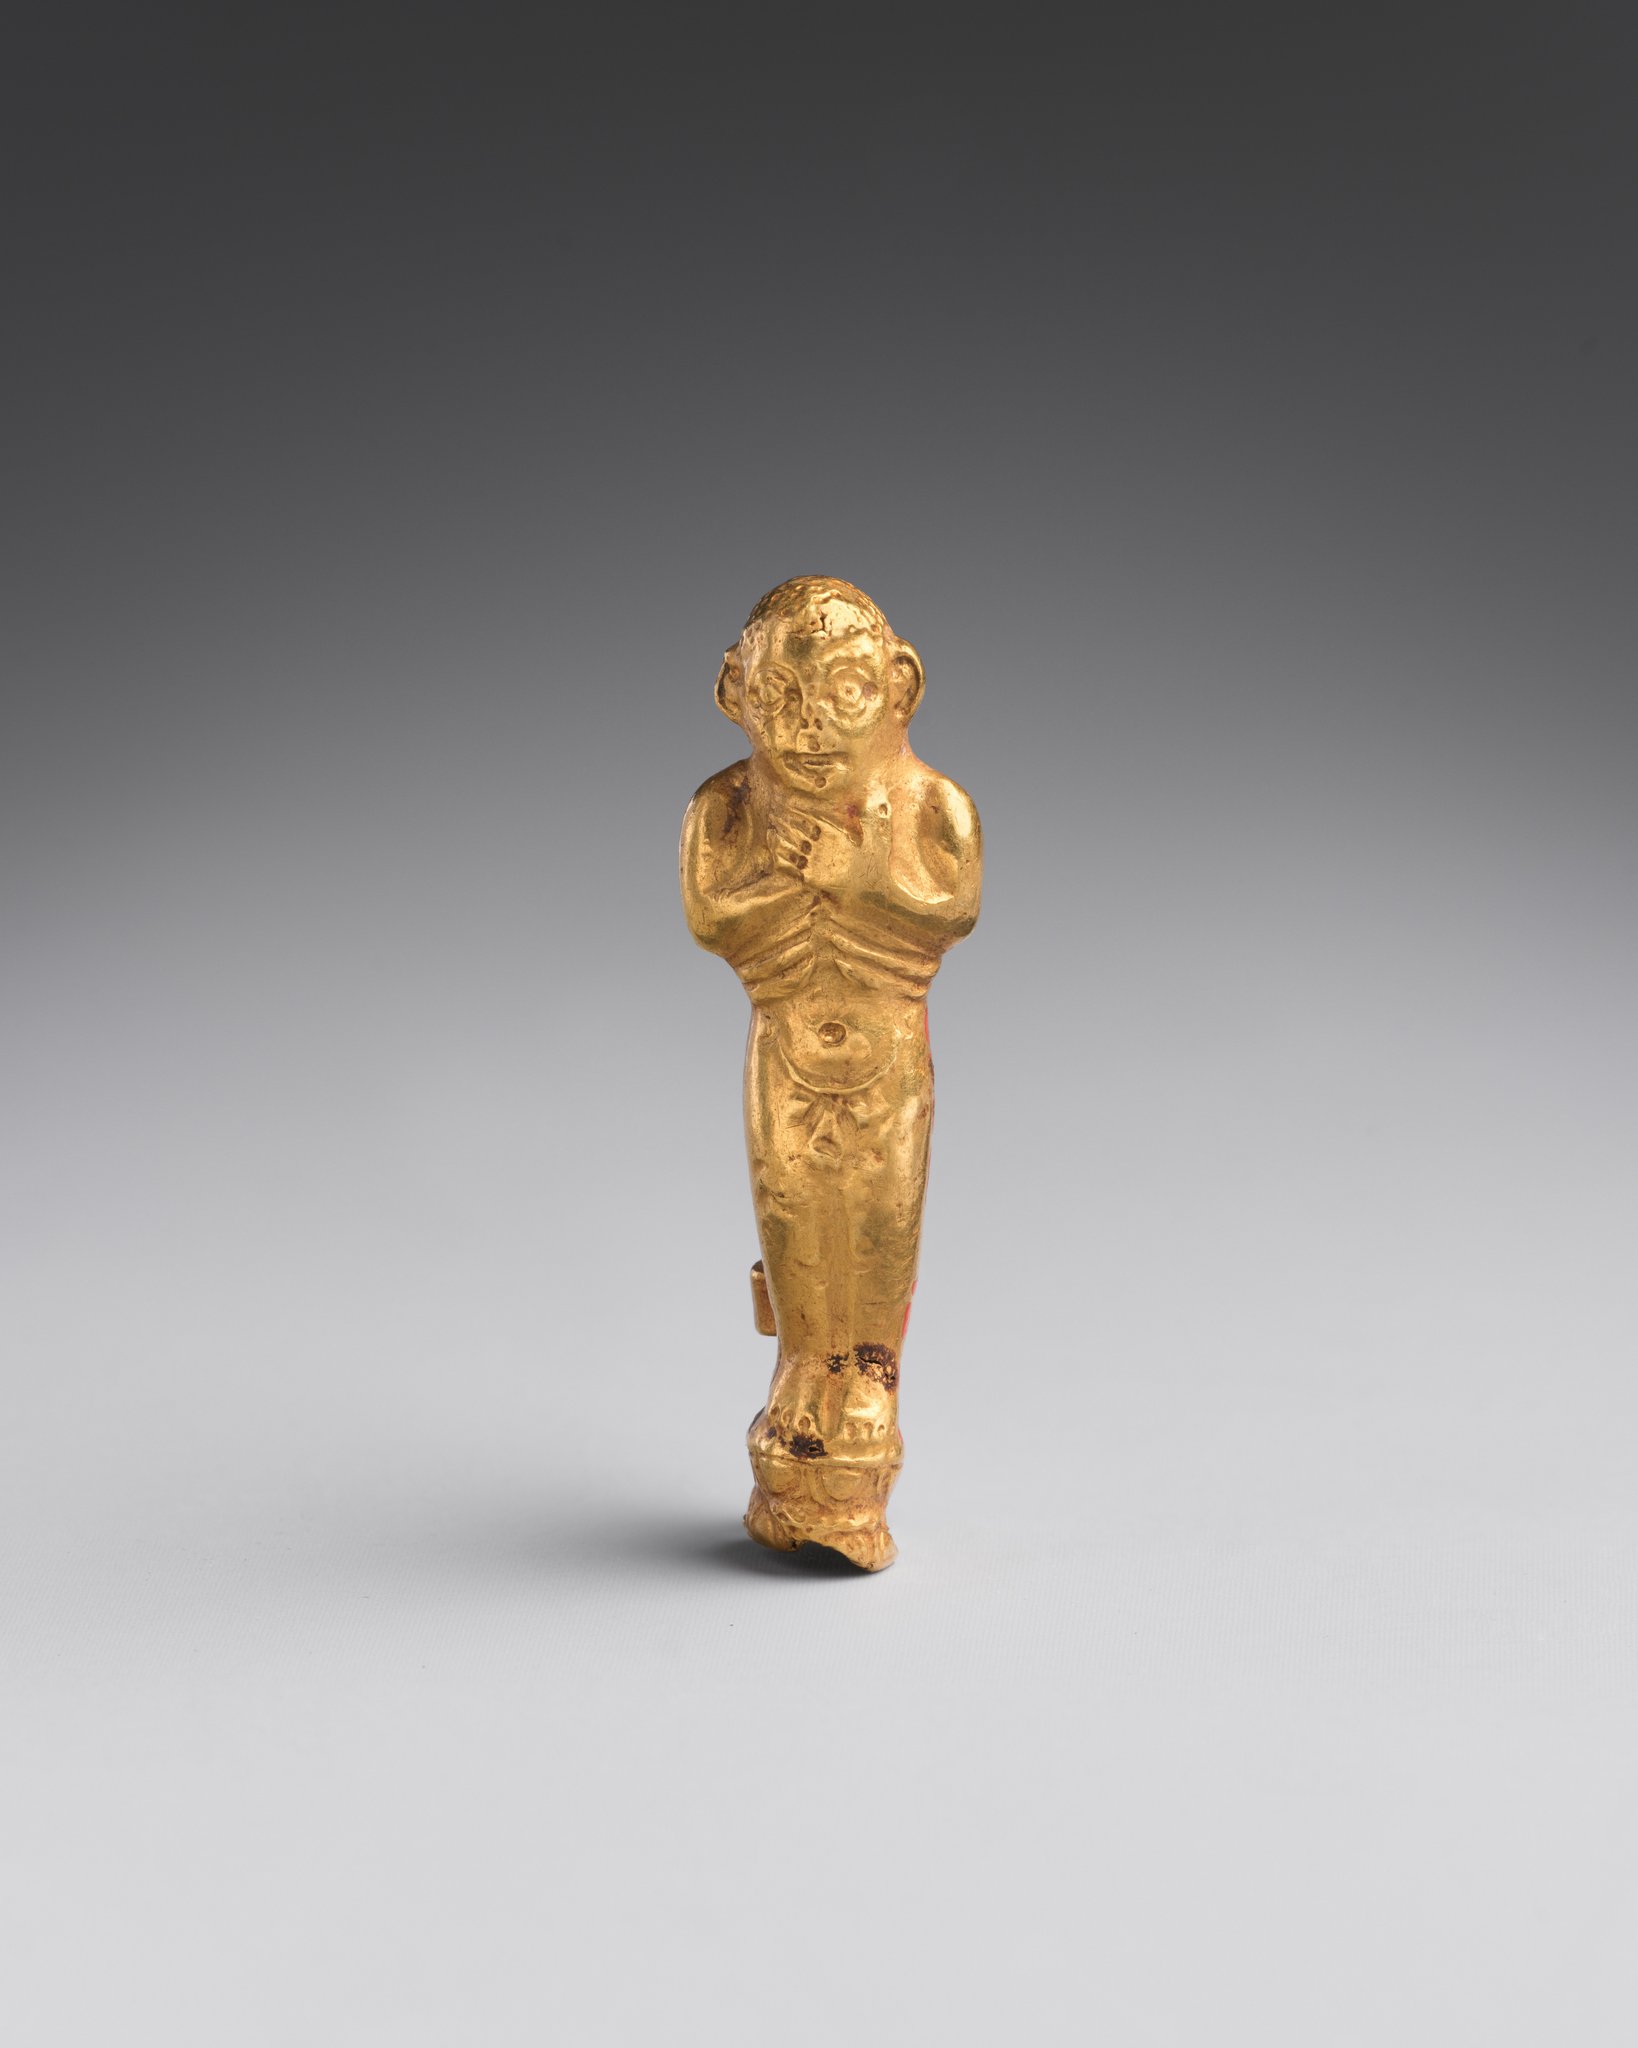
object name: pendant in the form of a goddess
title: Gold amulet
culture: cypro-phoenician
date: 600-301 BCE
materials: gold